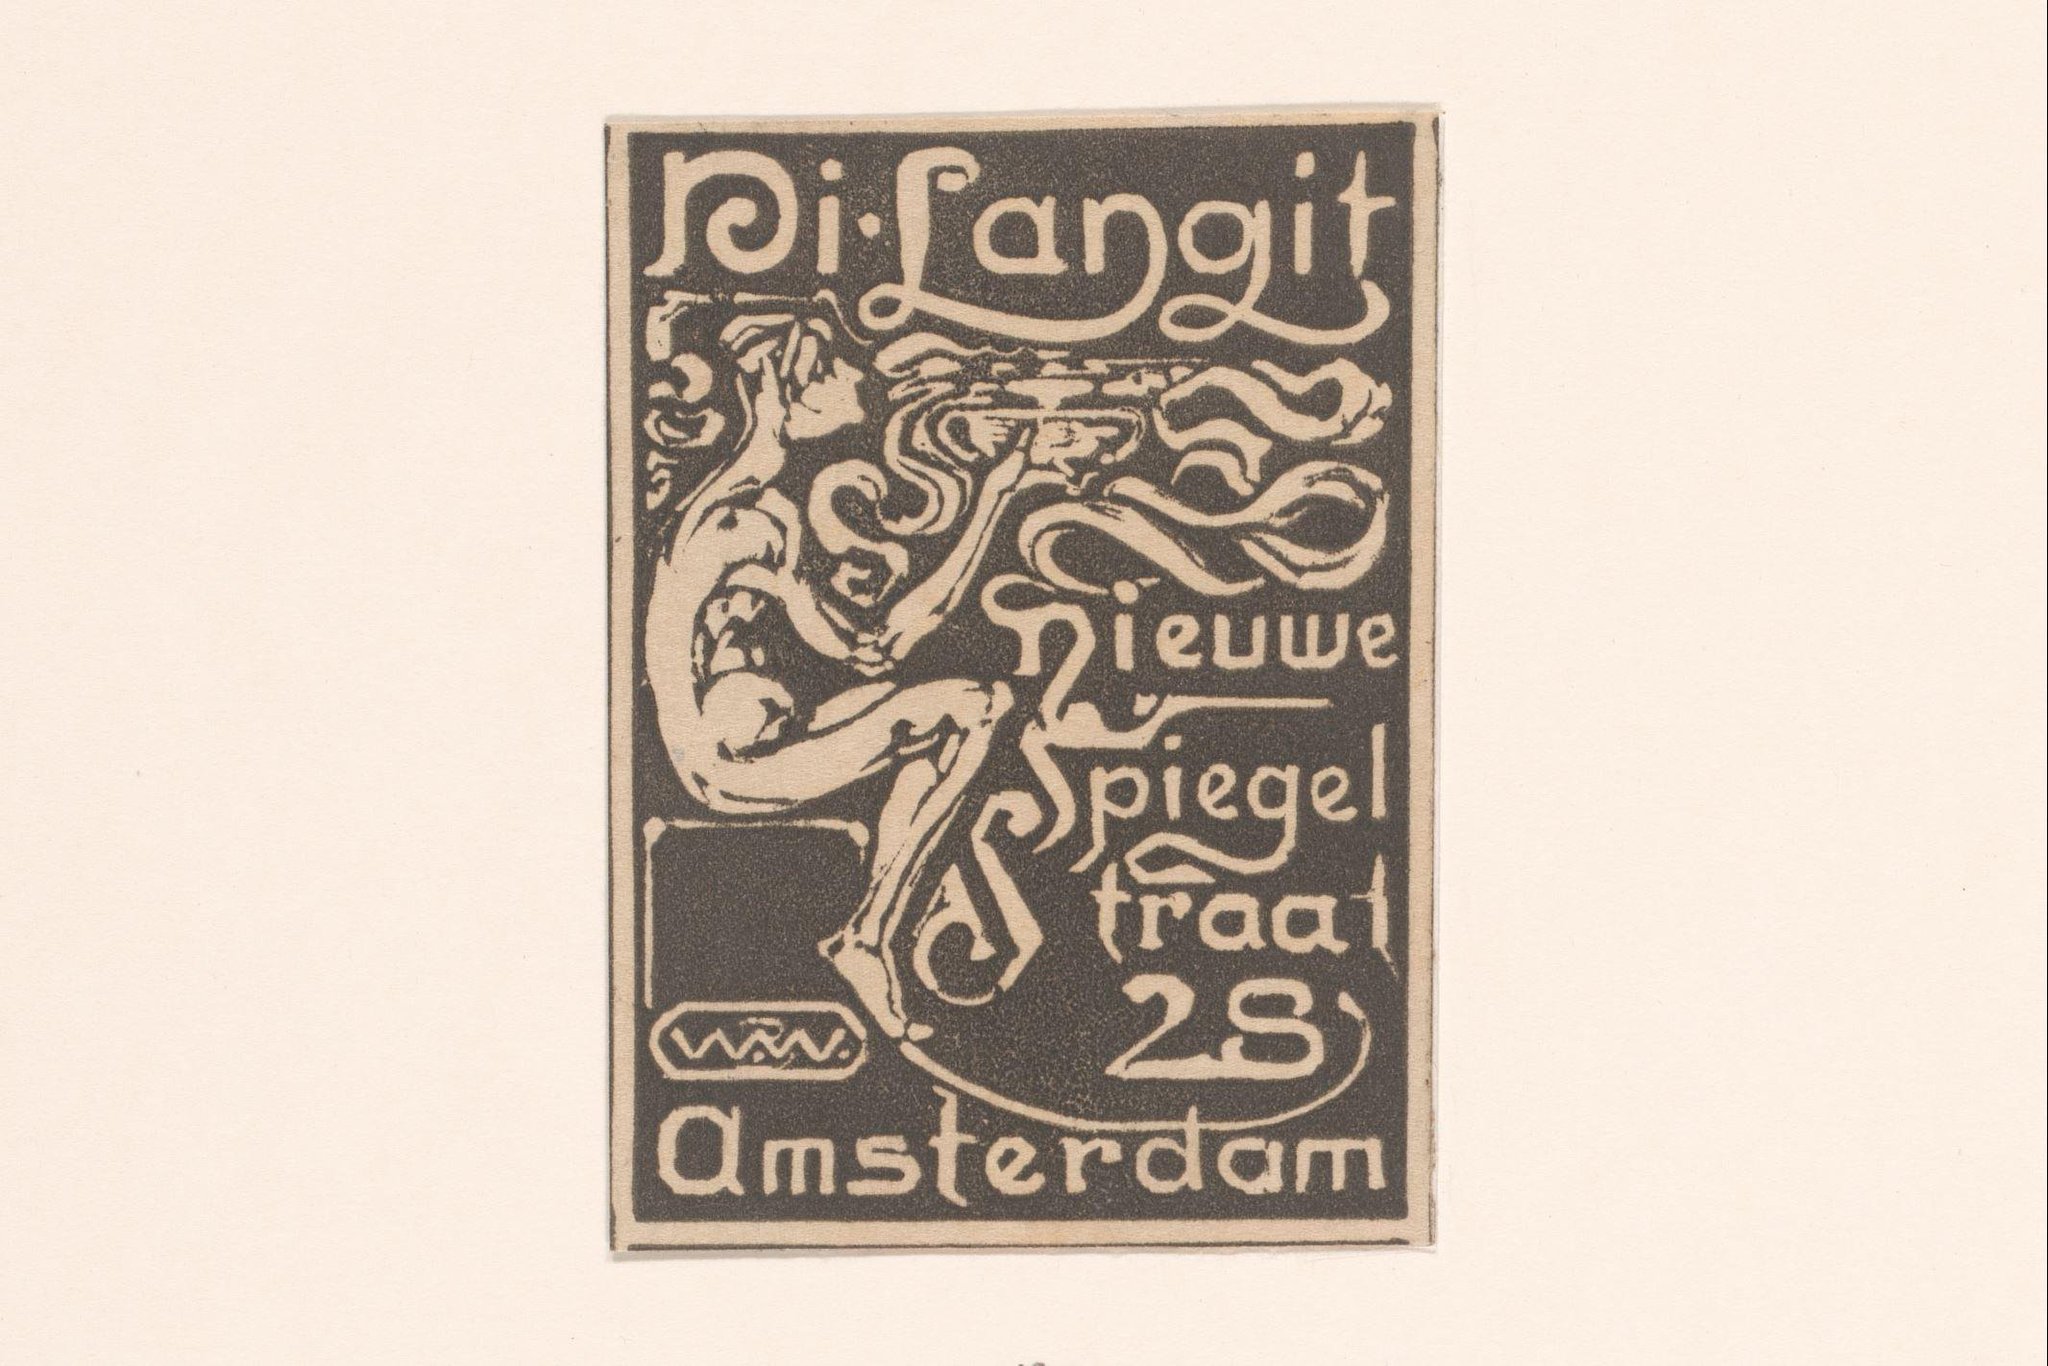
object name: print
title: Vignet voor Di Langit, Nieuwe Spiegelstraat 28 te Amsterdam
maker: bernard willem wierink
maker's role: draughtsman, print maker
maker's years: 1856-1939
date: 1866-1939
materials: paper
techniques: woodcut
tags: vignette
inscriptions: collector's mark: Lugt 2228, collector's mark: Lugt 2760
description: Deze prent is vermoedelijk een plaatsnede, ook al wordt in de literatuur veelal gesproken over een houtsnede. Voor zover Wierink zijn prenten in hoogdruk zelf nader heeft omschreven, heeft hij altijd de term 'plaatsnede' gebruikt.